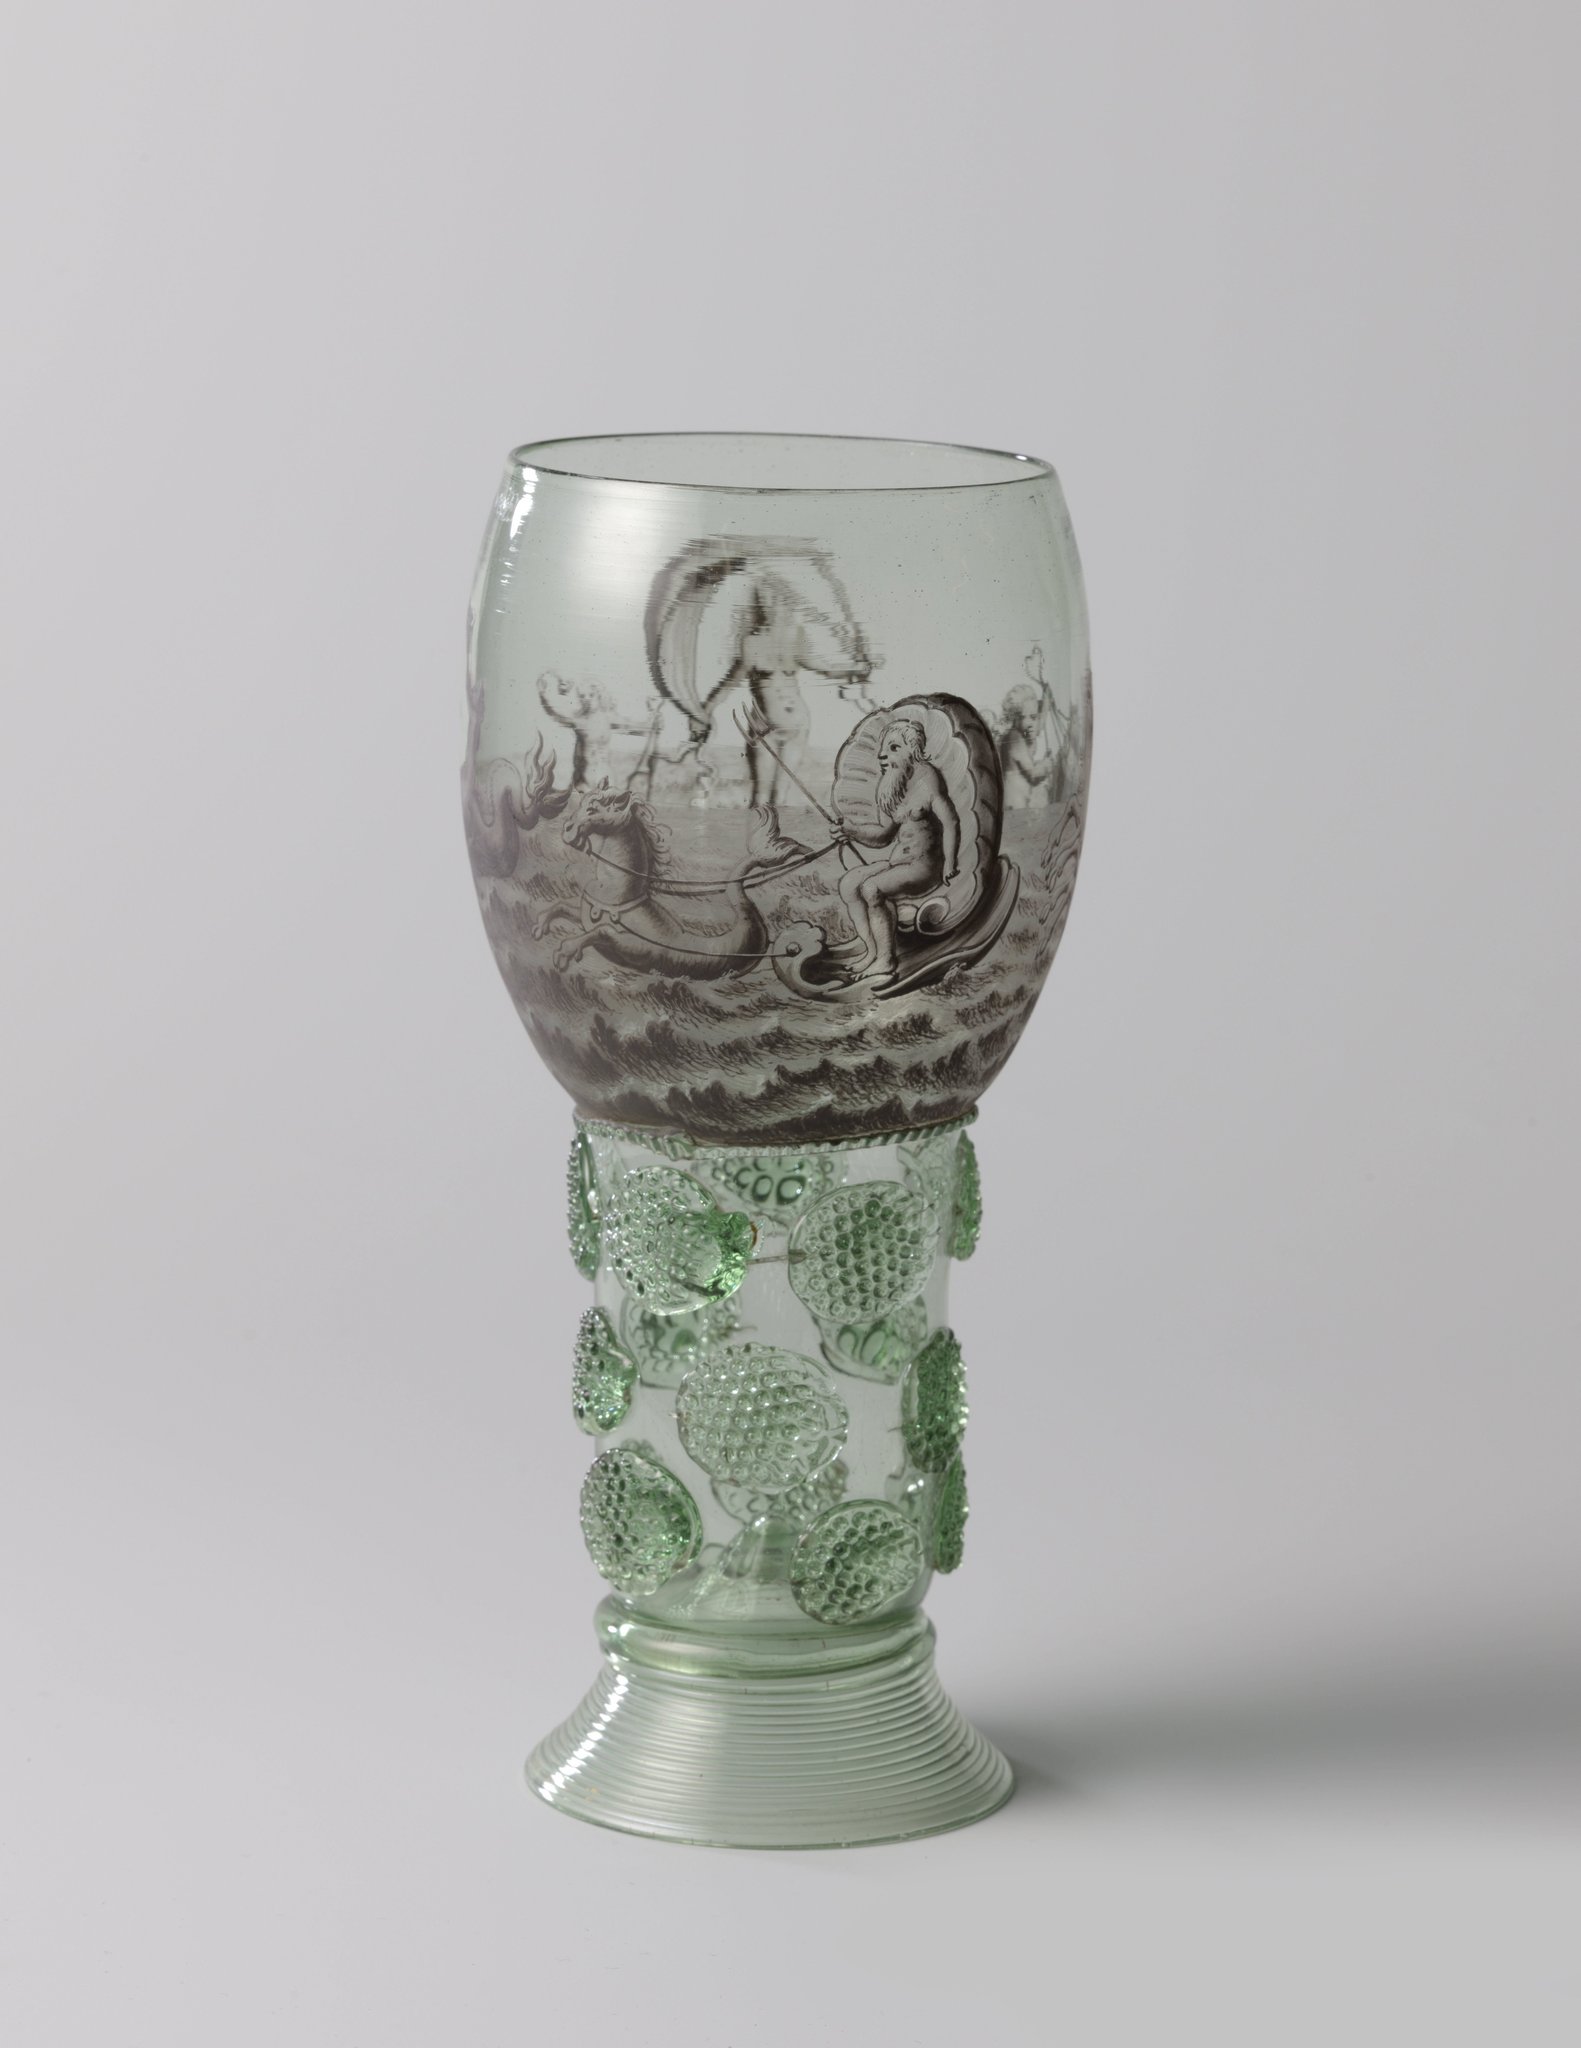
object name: roemer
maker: Anonymous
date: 1650-1700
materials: glass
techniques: glassblowing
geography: northern netherlands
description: In the 16th and 17th centuries, grisaille decorations were mainly painted on stained glass. This kind of monochrome decoration is much rarer on ‘hollow glass,’ such as this roemer. Here we see Neptune being pulled through the waves in his sea chariot, a scene portraying a passage from the myth of Aeneas. The ruler of the sea calms the storm so that Aeneas and his companions can reach the shore safely.